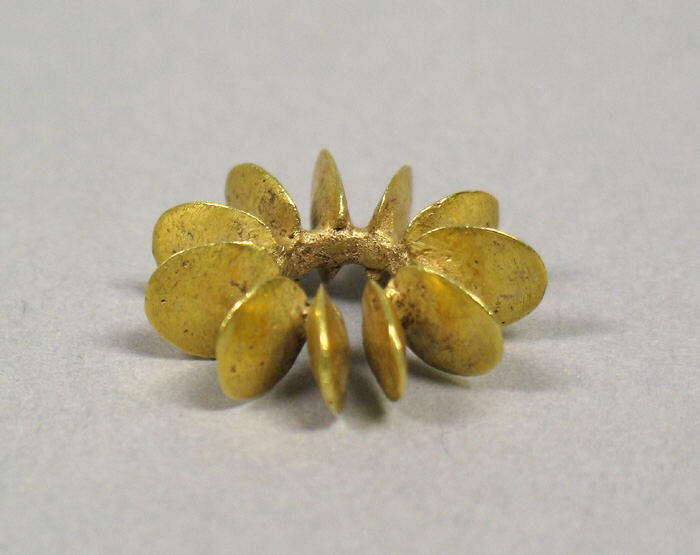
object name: ear ornament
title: Ear Ornament, Eleven Fused Disks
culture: indonesian, central java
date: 701-1200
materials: gold